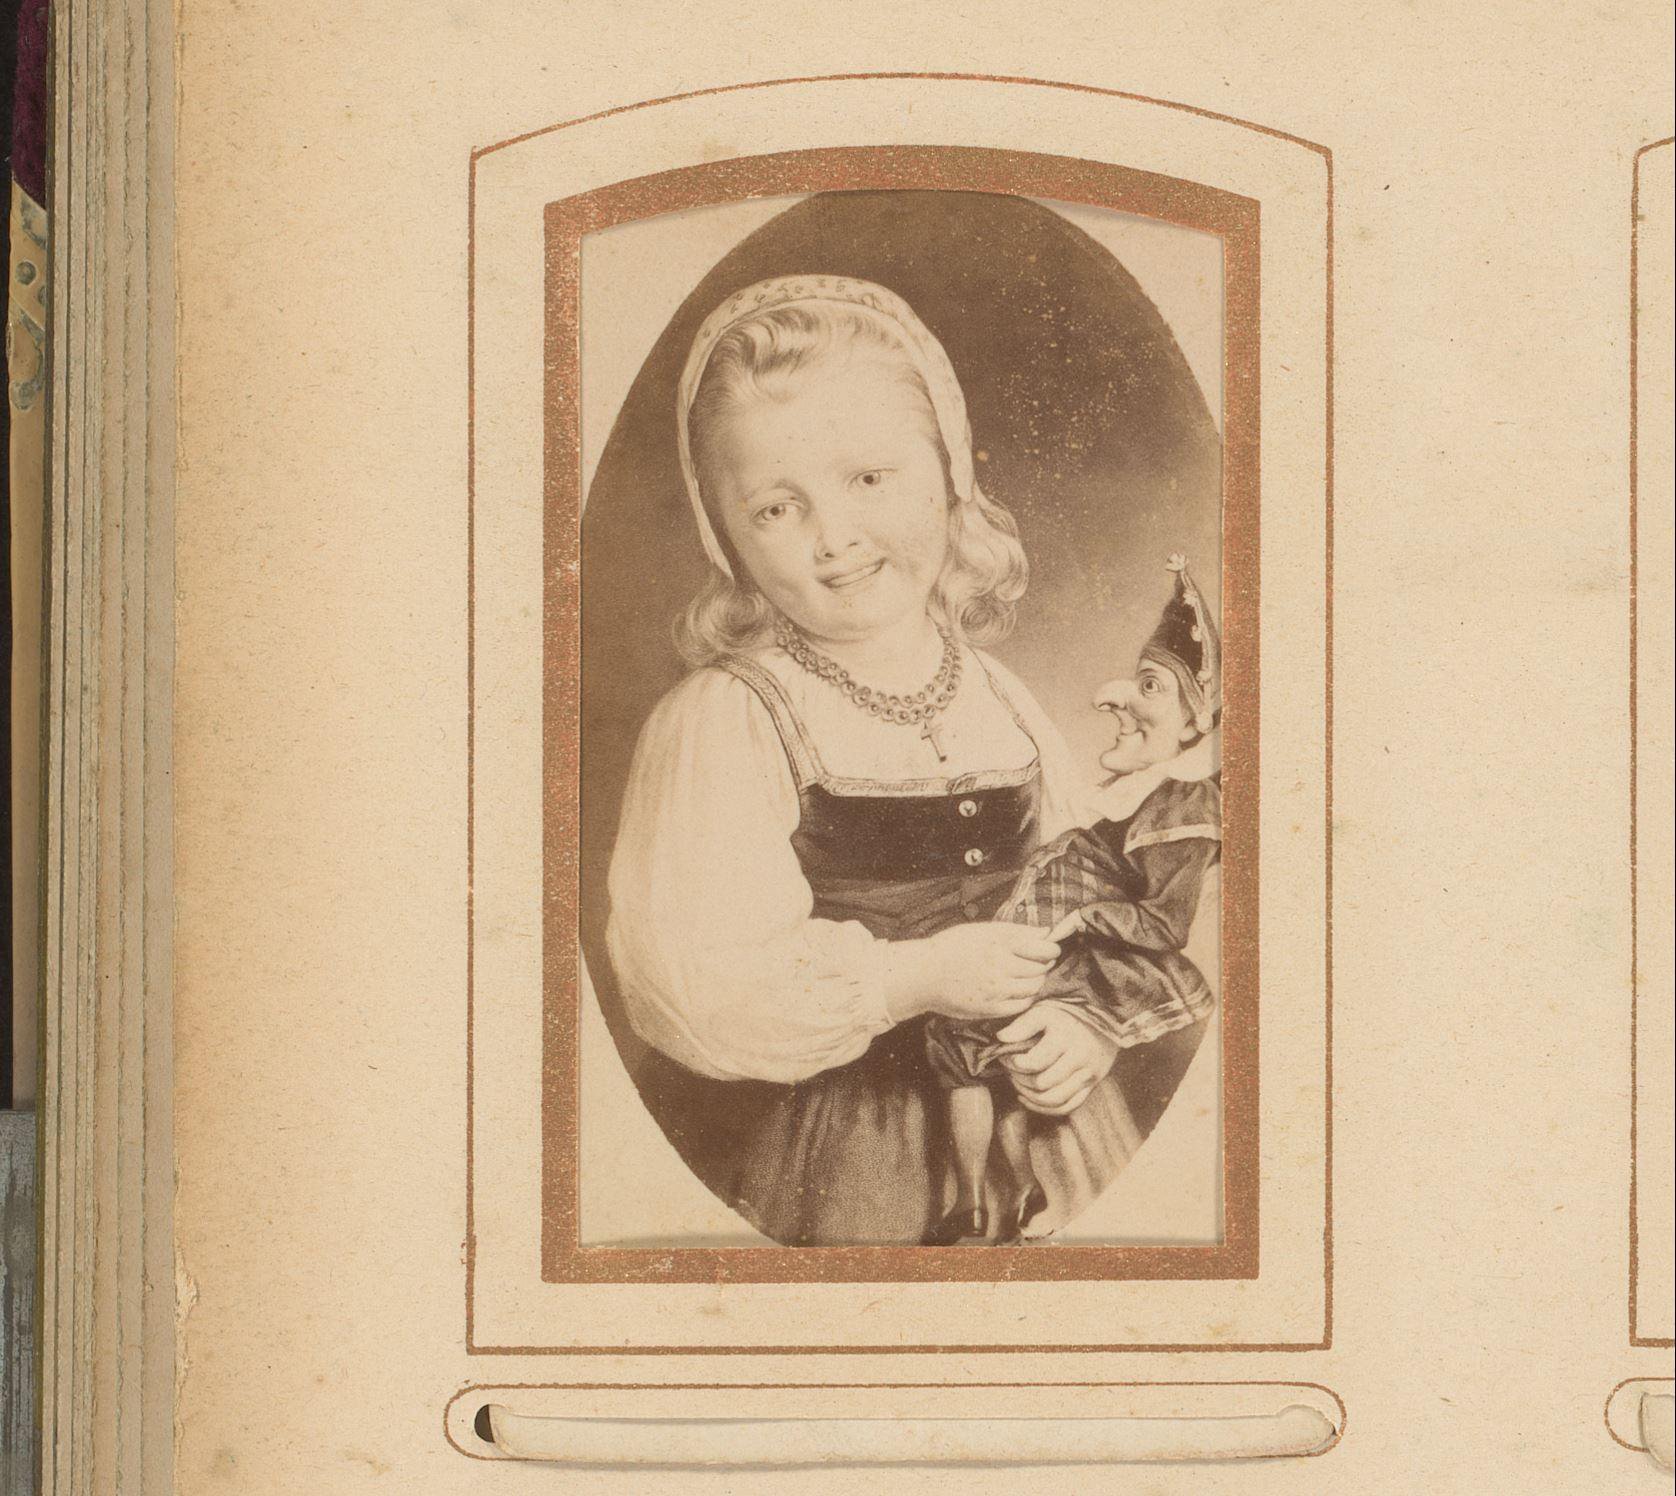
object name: reproduction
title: Fotoreproductie van een geschilderd portret van een blij kijkend meisje met een pop op de arm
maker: Anonymous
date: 1850-1900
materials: cardboard, photographic support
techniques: albumen print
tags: historical persons - bb - woman, (playing with) dolls, toddler (female), happiness, felicity